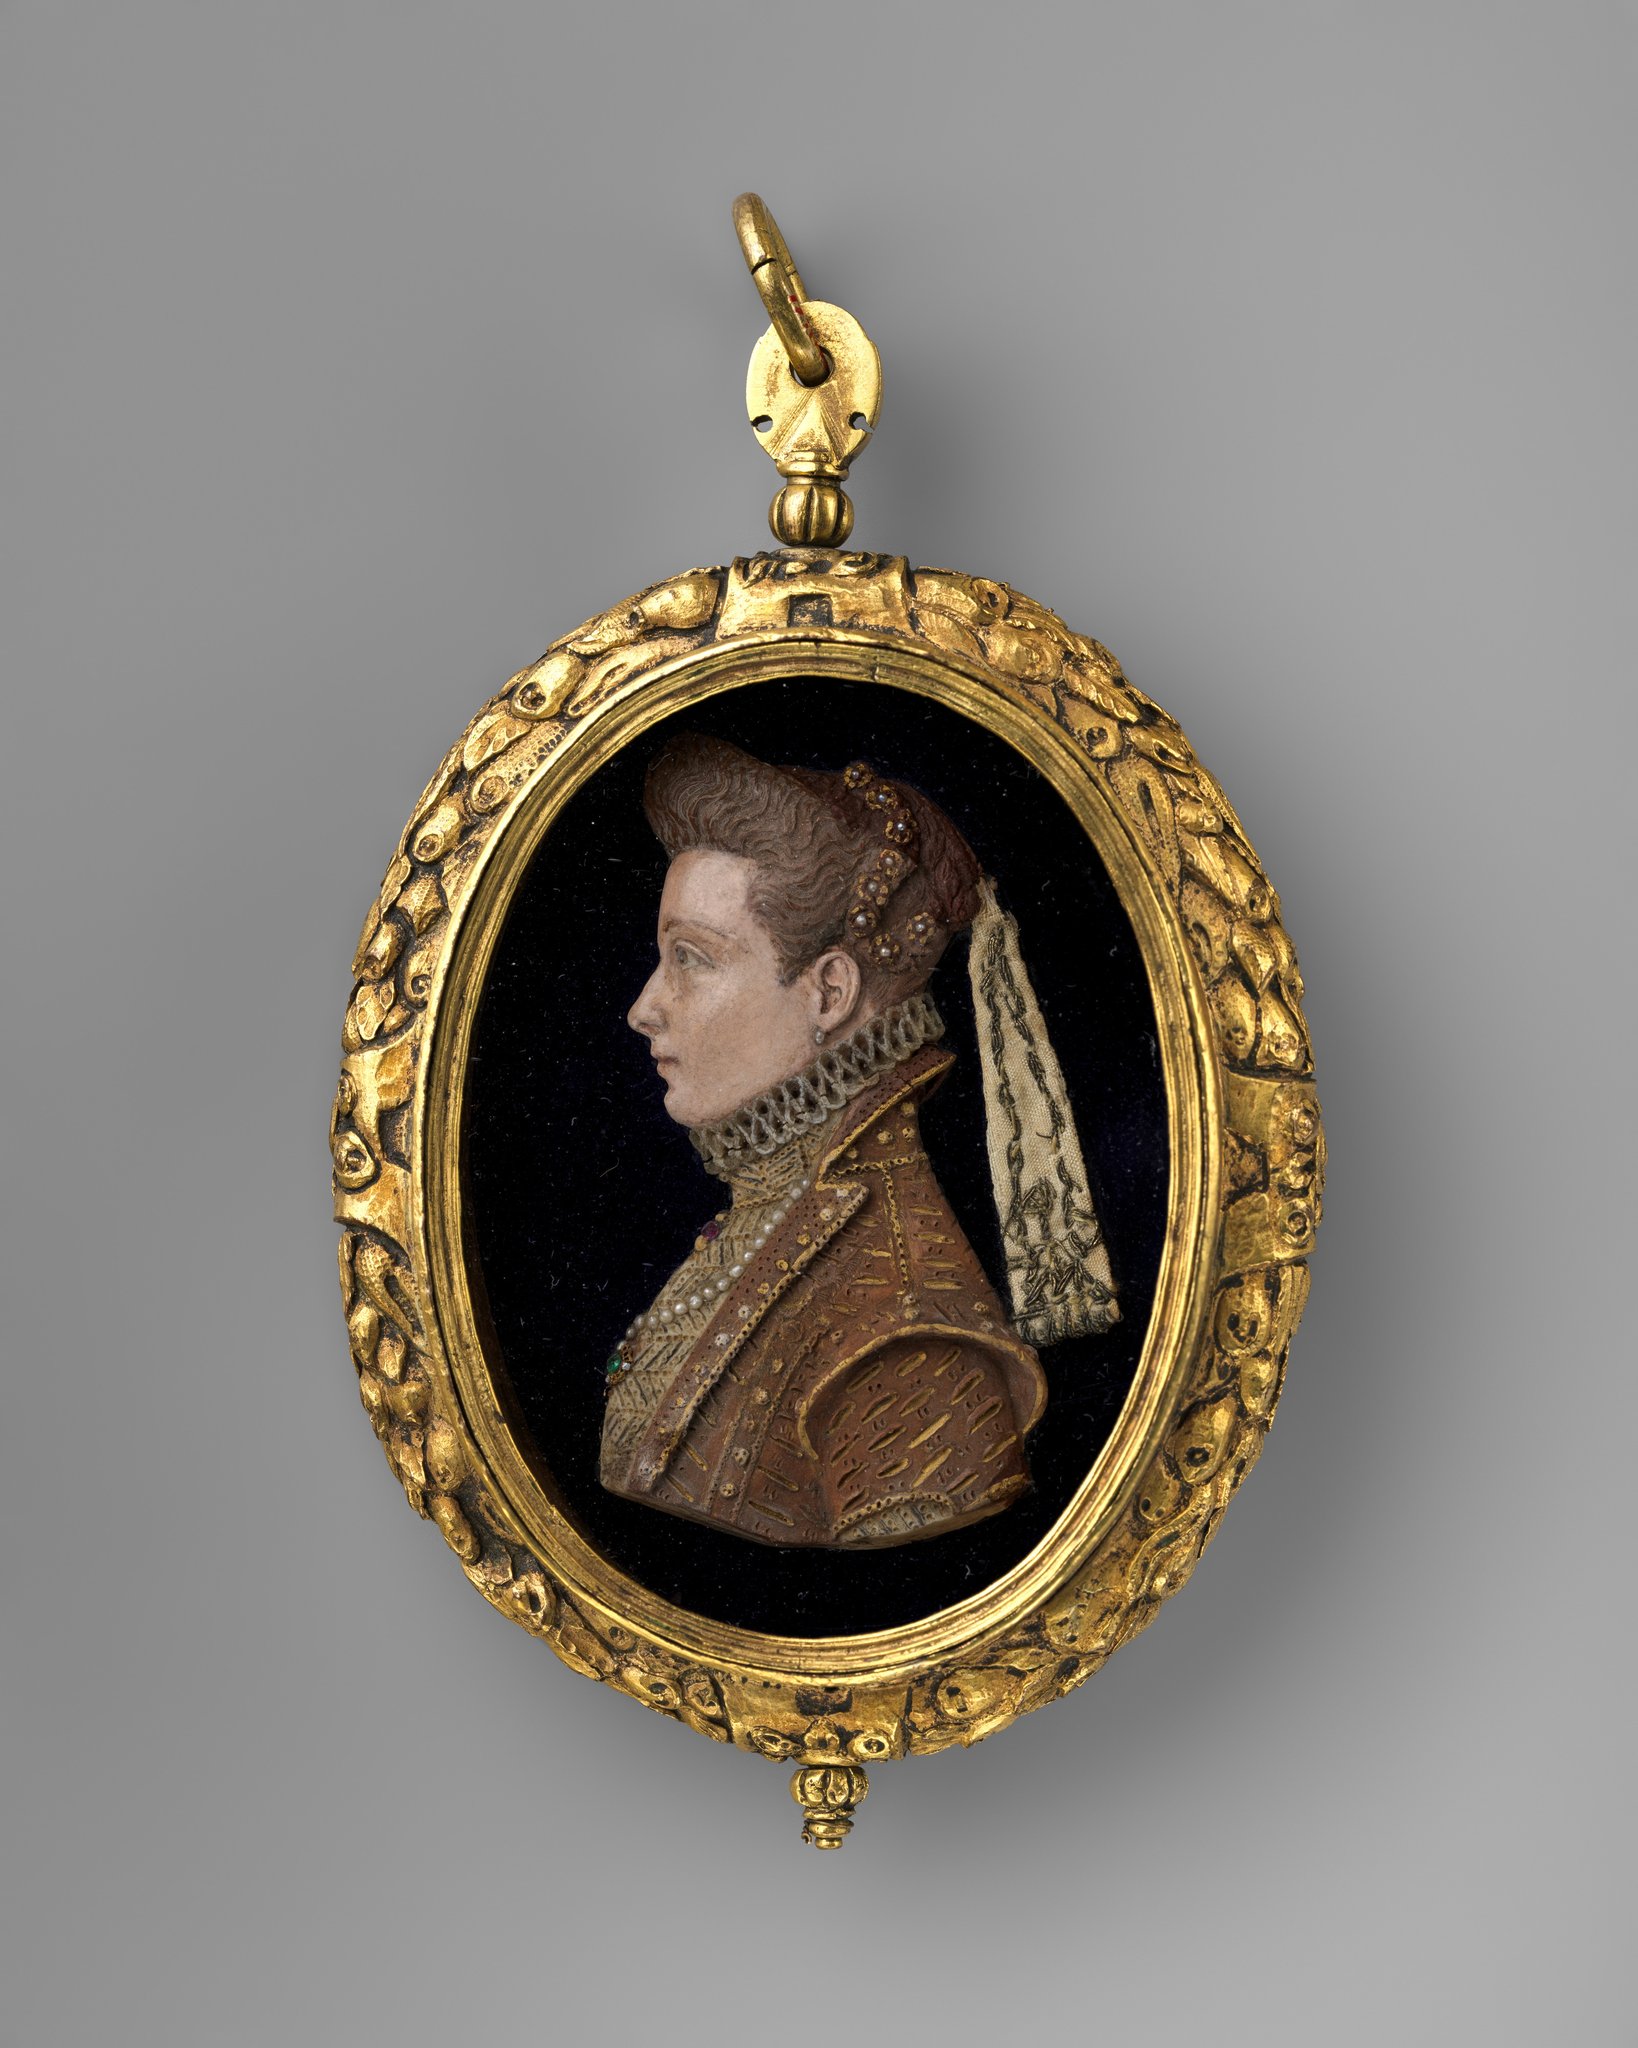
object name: portrait and case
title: Portrait of a lady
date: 1560-1580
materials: alloy, brass, gemstone, gilt copper, glass, linen, metal thread, pearl, wax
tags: profiles,women